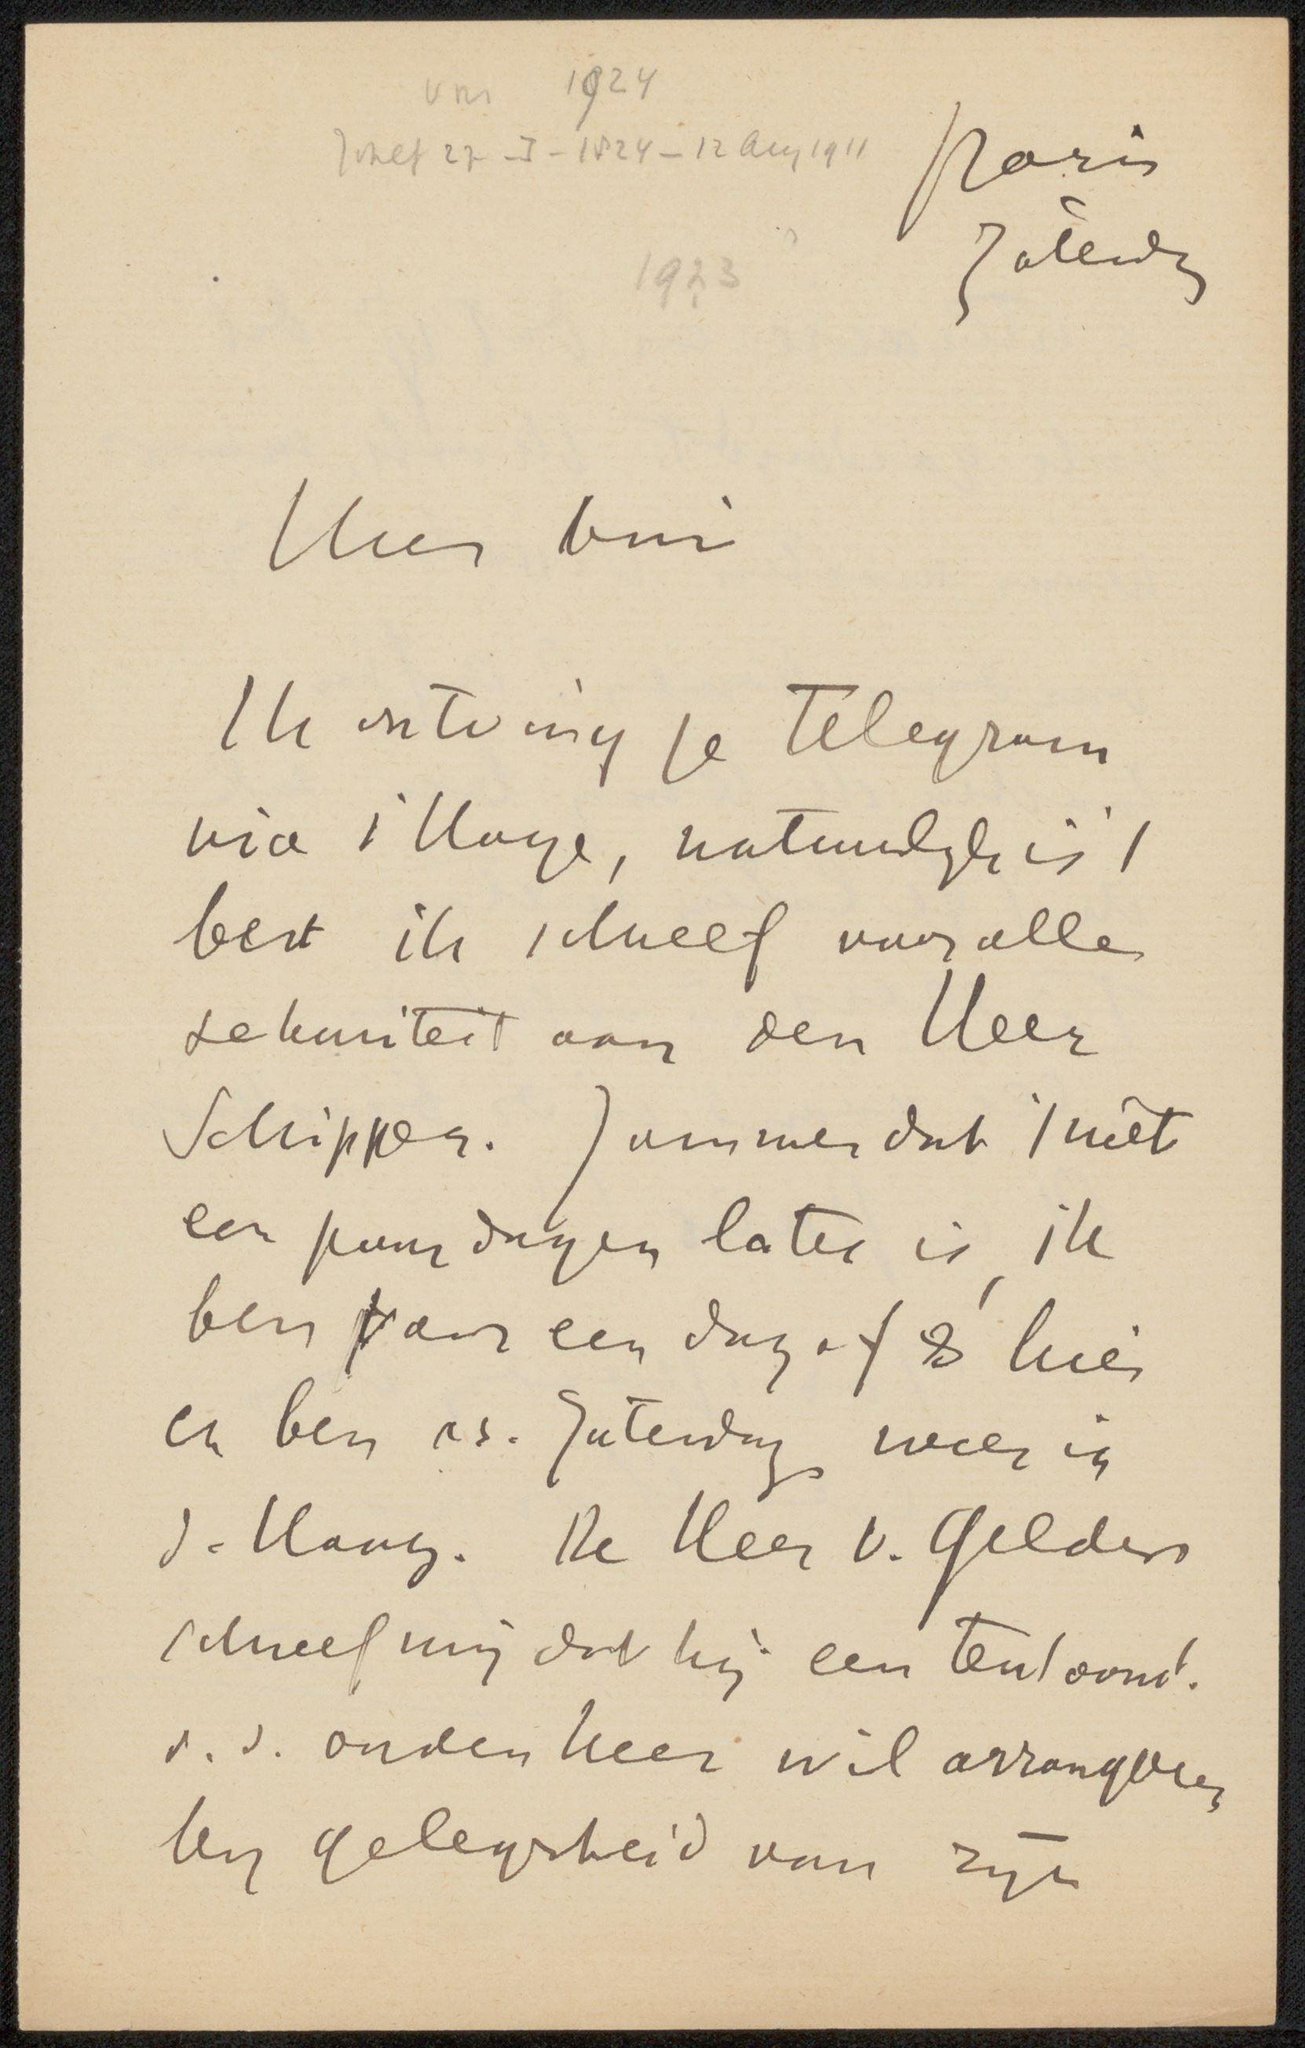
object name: letter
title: Brief aan Jan Veth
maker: isaac israels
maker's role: draughtsman, painter, print maker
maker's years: 1865-1934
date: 1875-1925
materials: ink, paper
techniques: pen, writing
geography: paris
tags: dordrecht, painter, print maker, draughtsman, designer, jan veth, the hague, hendrik enno van gelder, painting (including book-illumination, miniature-painting), exhibition ~ art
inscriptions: collector's mark: ‘RPK’